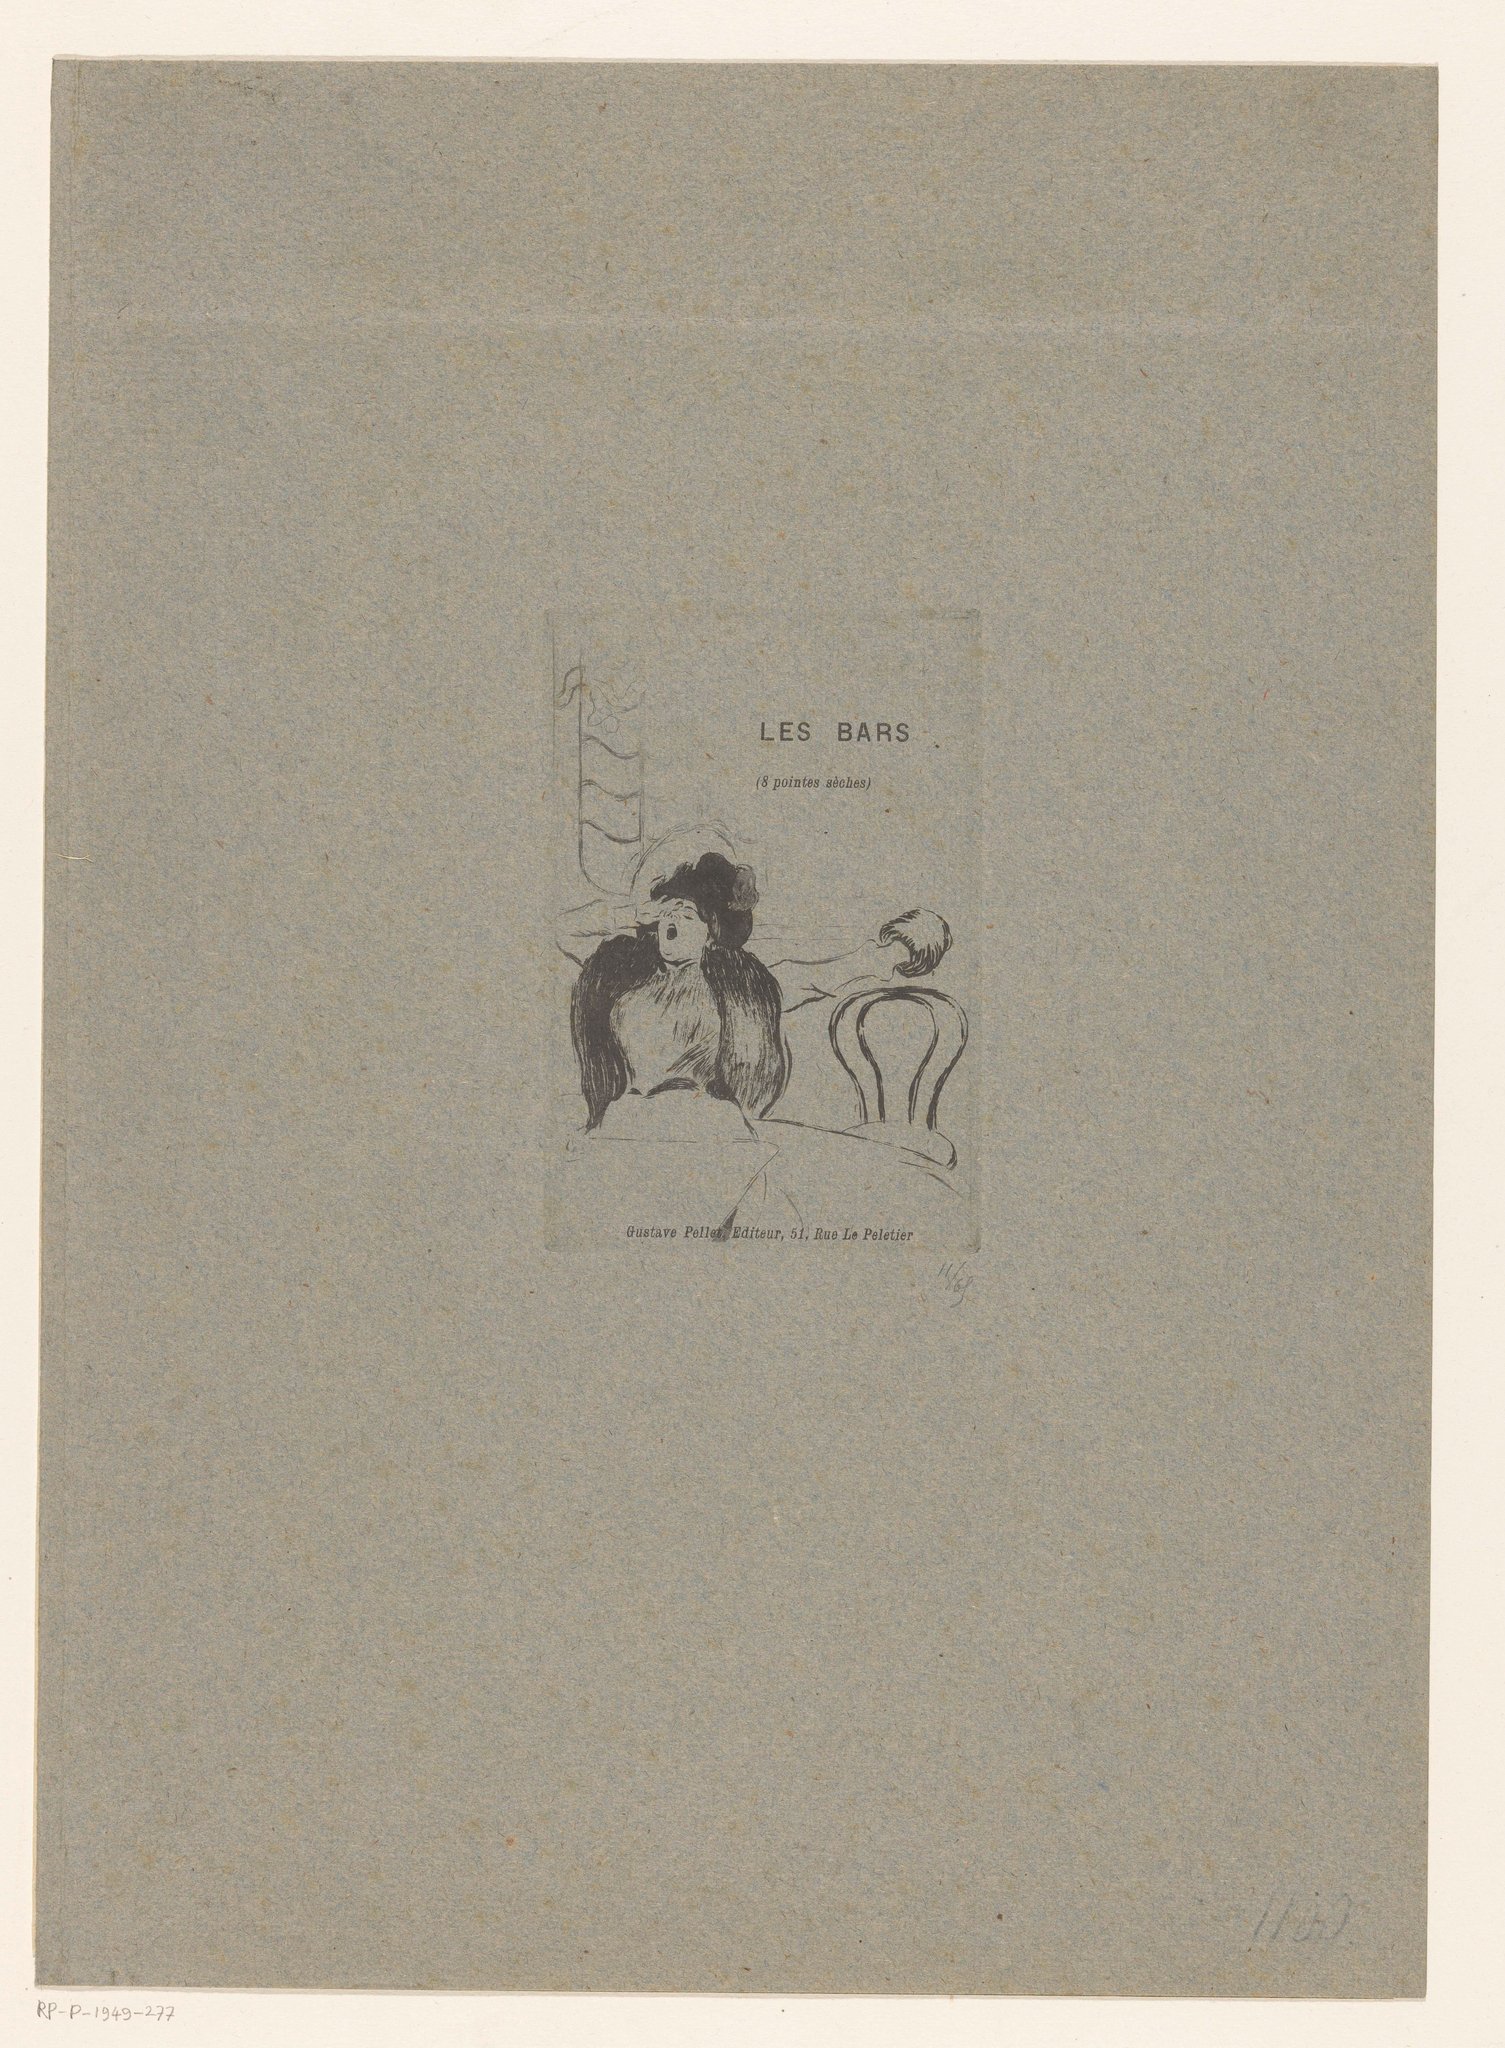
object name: print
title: Omslag voor: Les Bars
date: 1909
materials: paper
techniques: drypoint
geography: france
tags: inn, coffee-house, public house, etc., yawning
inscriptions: collector's mark: Lugt 2228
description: Omslag voor een serie getiteld: "Les Bars", bestaande uit acht platen, uitgegeven door Gustave Pellet in 1909.